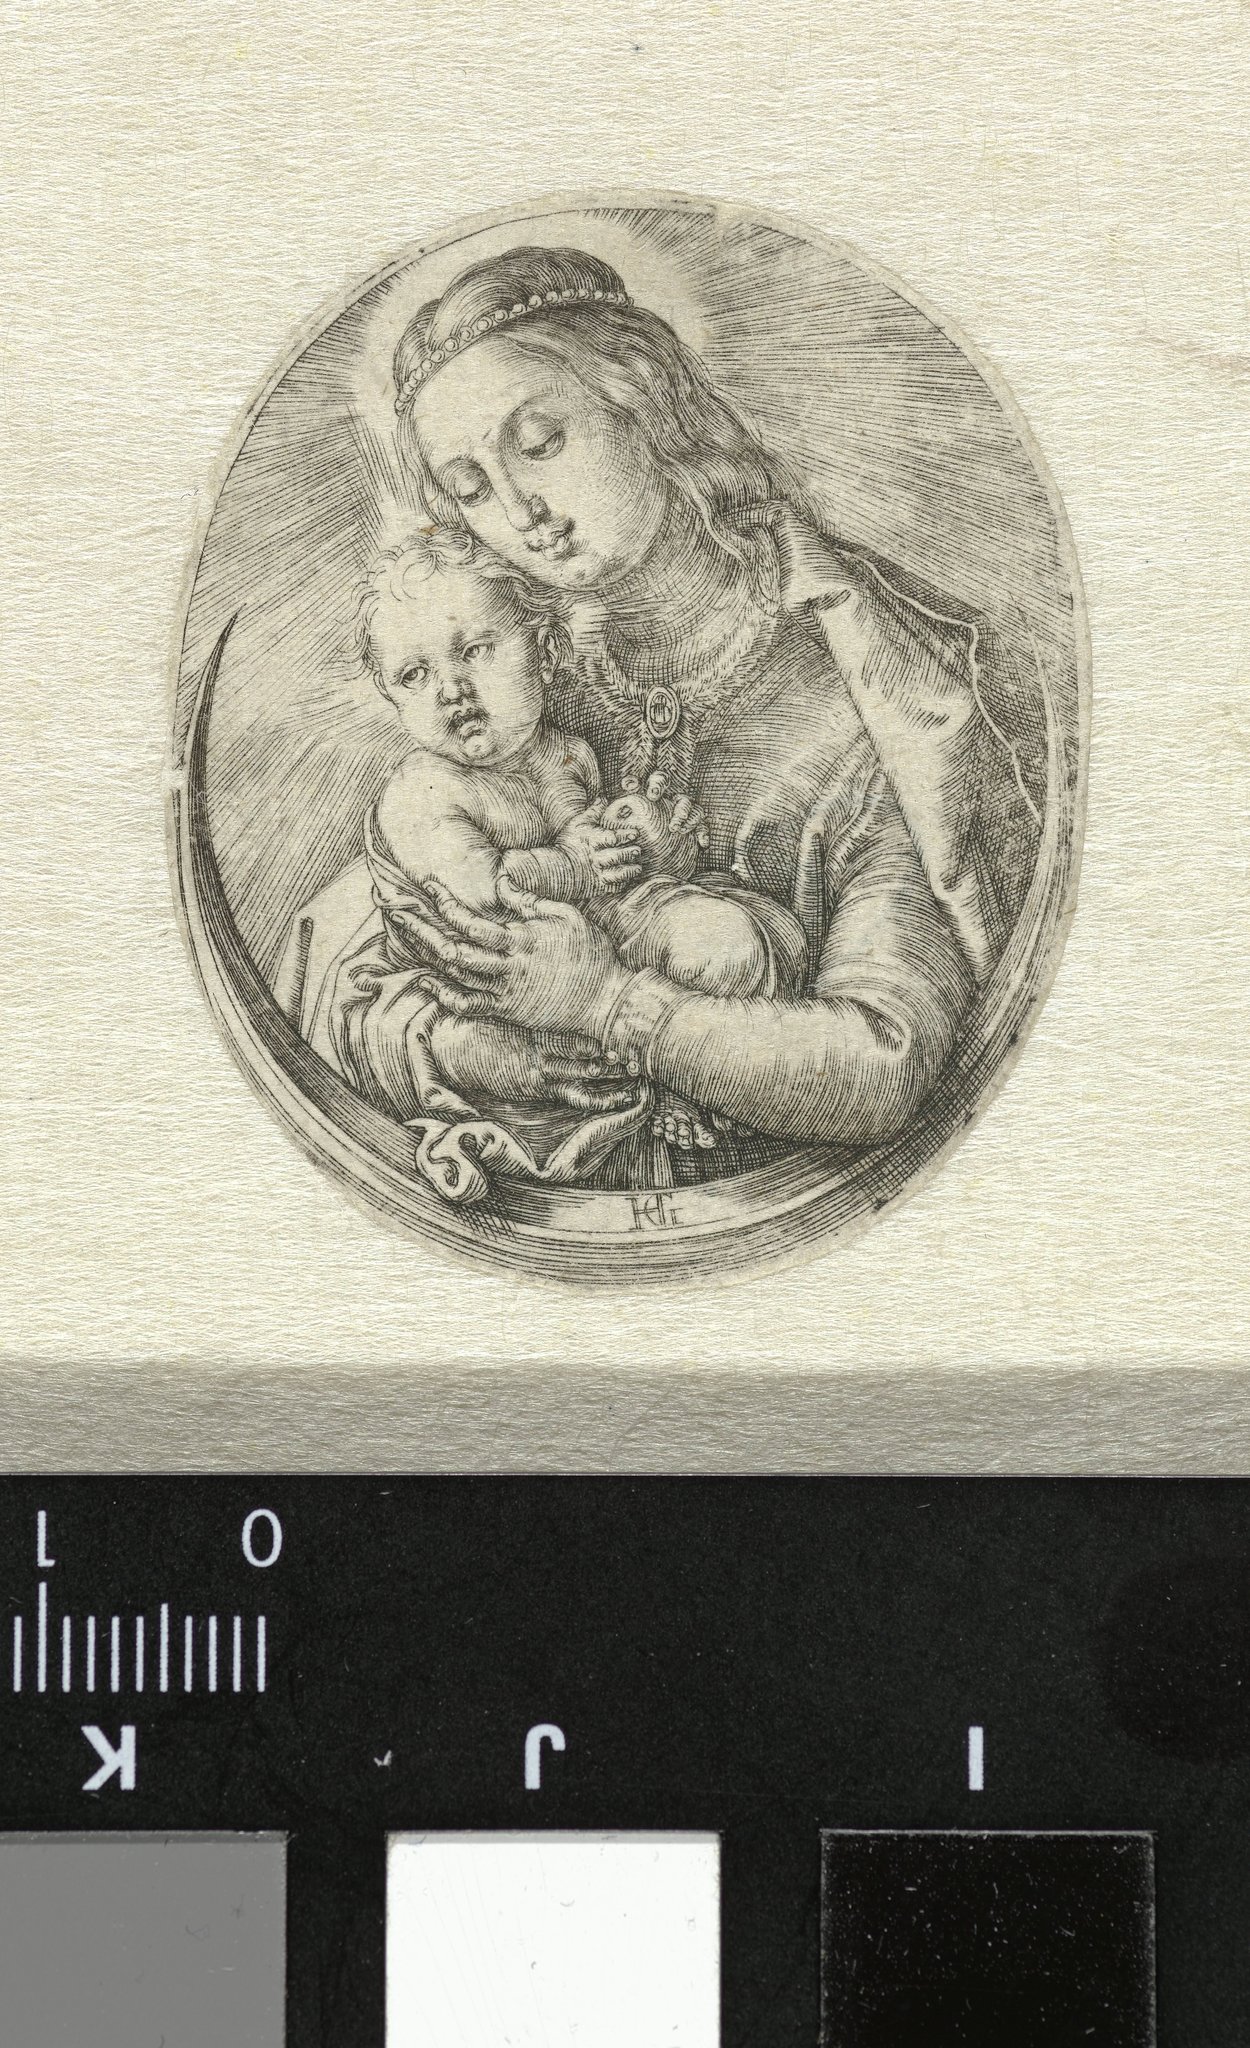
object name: print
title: Maria met Christuskind op een halve maan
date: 1593-1597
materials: paper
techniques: engraving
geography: haarlem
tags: madonna on the crescent of the moon (sometimes called queen of heaven) (in mandorla), mary standing (or half-length), the christ-child in front of her, close to her bosom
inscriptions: collector's mark: Lugt 2228a, monogram: ‘HG’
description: Maria, ten halven lijve in ovaal afgebeeld met het Christuskind in de armen. Deze compositie wordt aan de onderkant omlijst door een maansikkel.